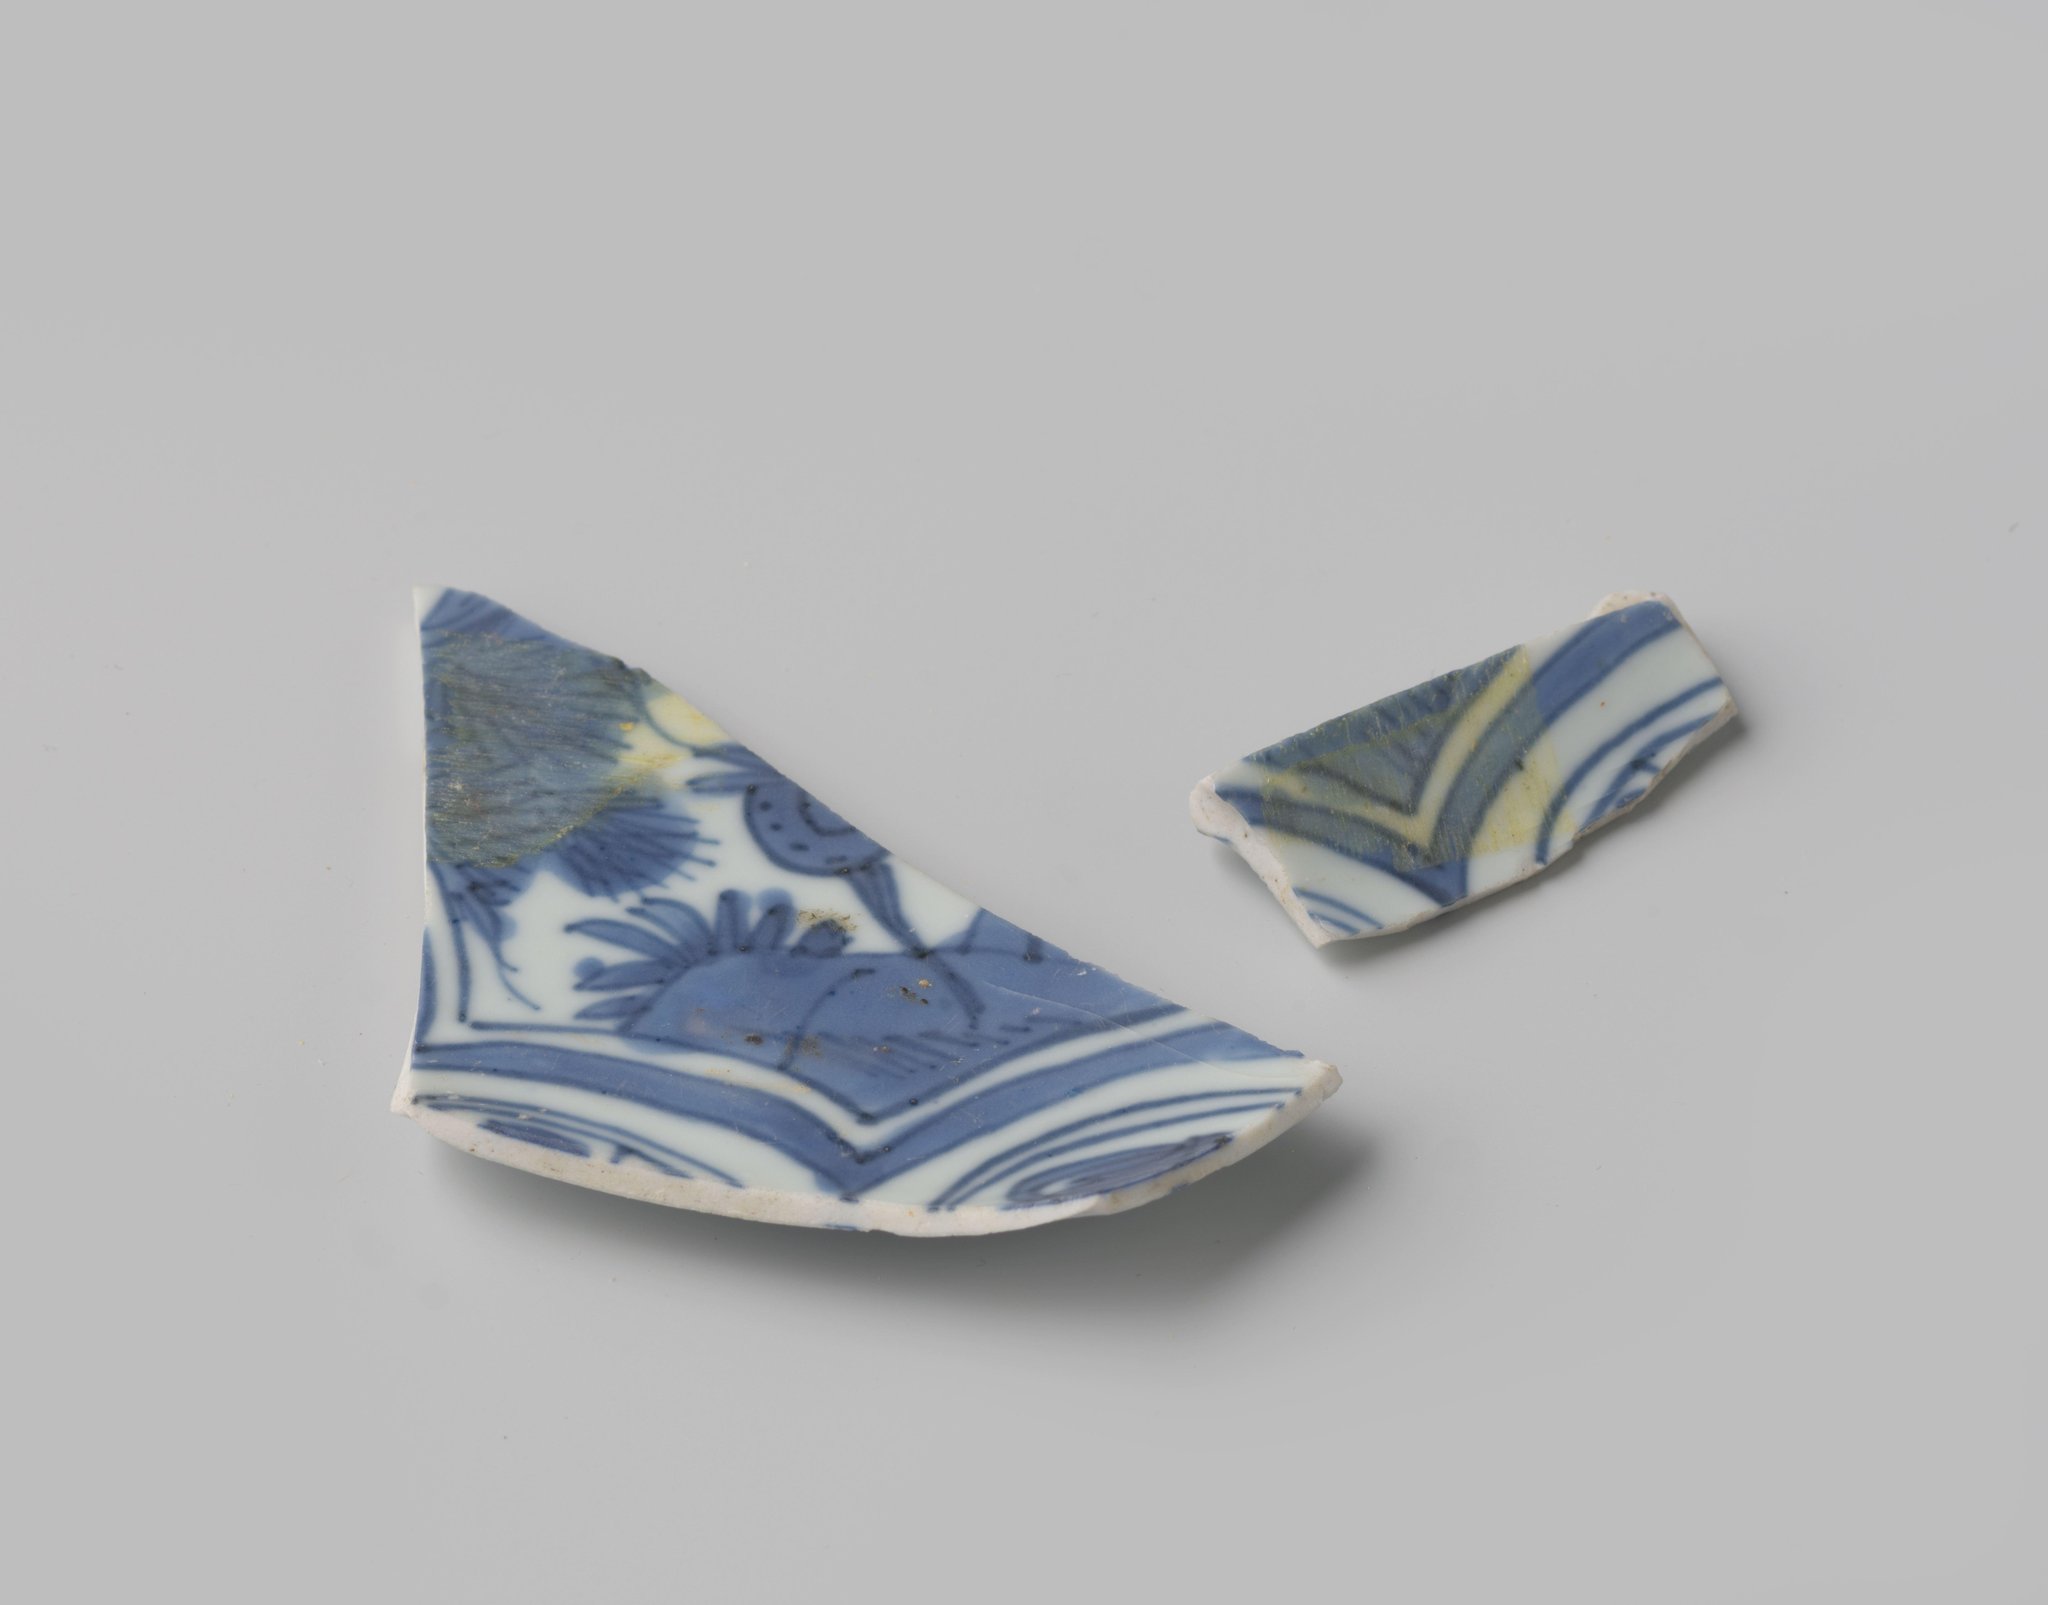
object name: bowl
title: Scherven van een bord of kom uit V.O.C.-schip de 'Witte Leeuw'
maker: Anonymous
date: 1613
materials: bone china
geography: jingdezhen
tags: verenigde oostindische compagnie, sint-helena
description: A saucer without a flattened rim. A central decoration of symbols. Base mark: jingzi i.e. a well made object.